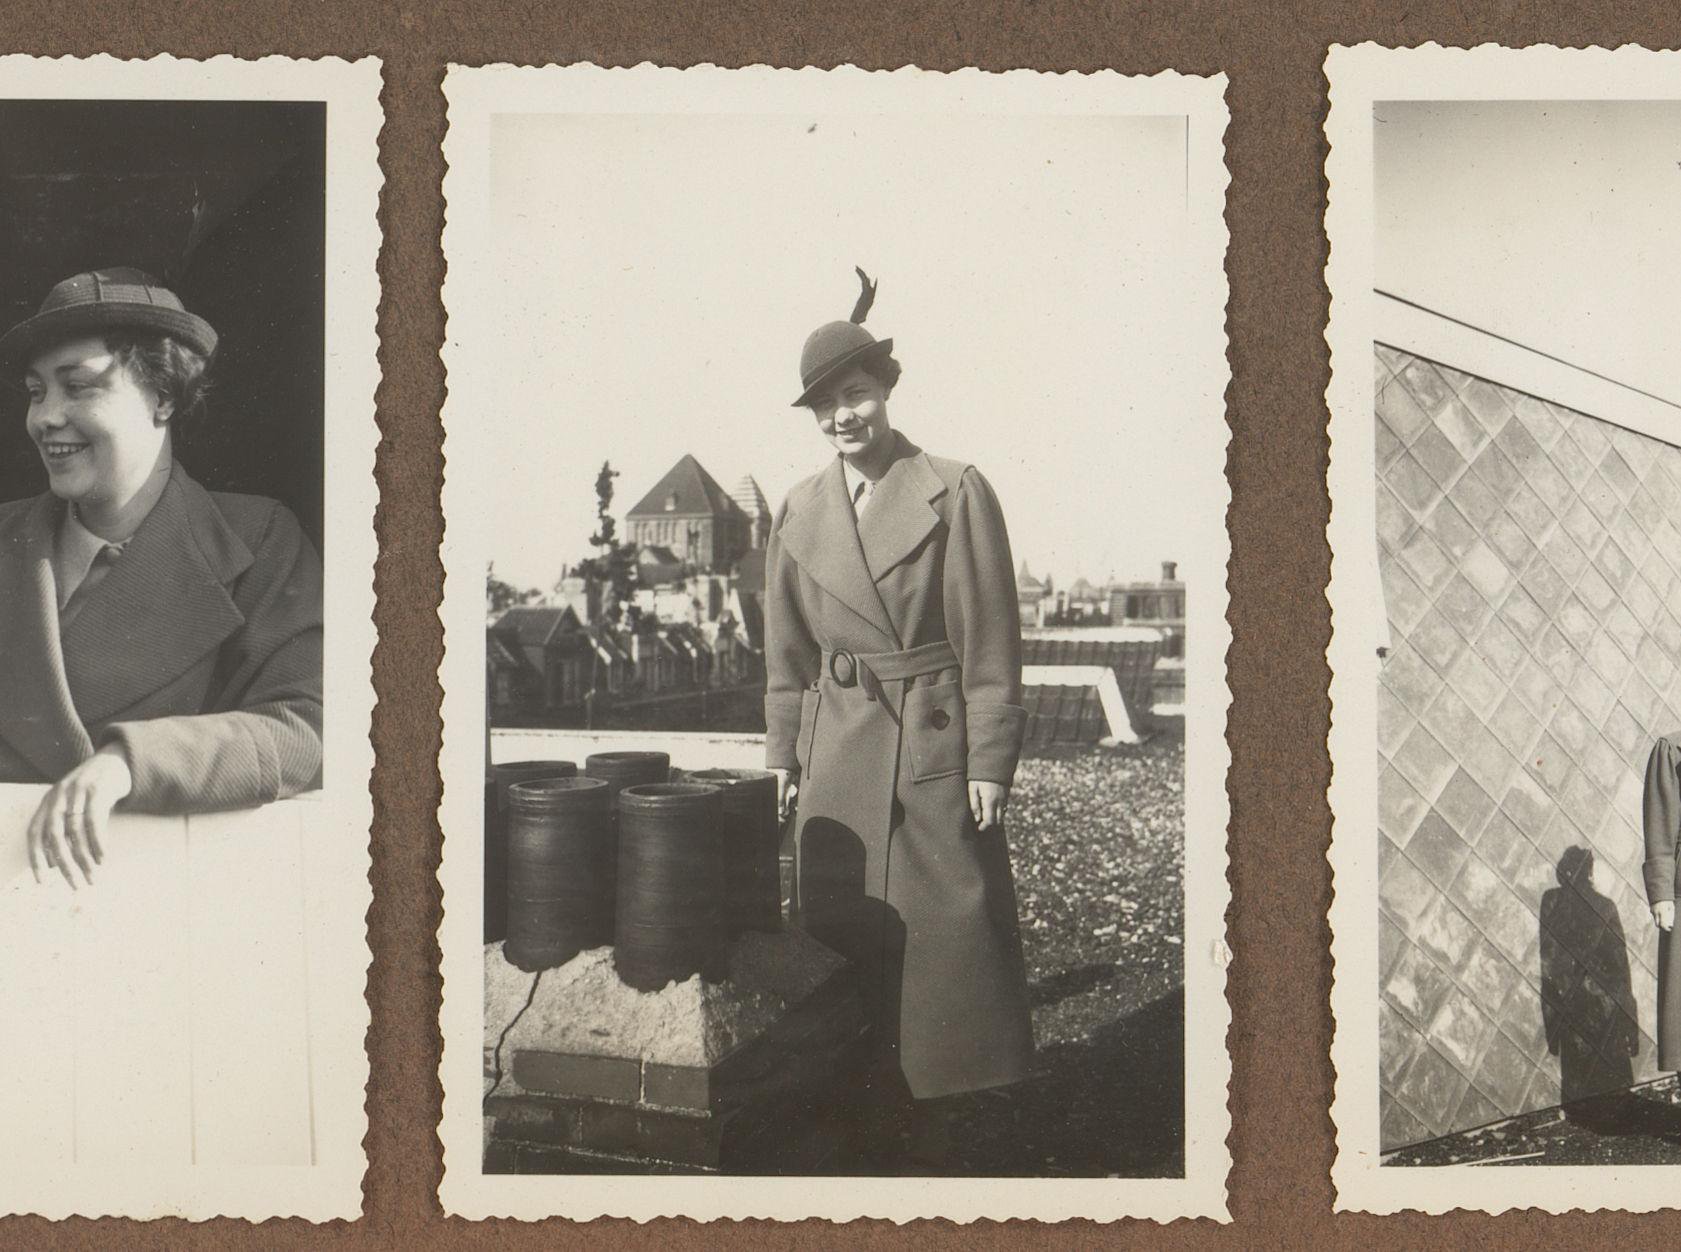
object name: photograph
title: Vrouw op Amsterdams dak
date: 1900-1920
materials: photographic support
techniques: photography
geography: amsterdam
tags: amsterdam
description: Foto op bruin albumblad 55 van familiealbum van Alphons Diepenbrock.